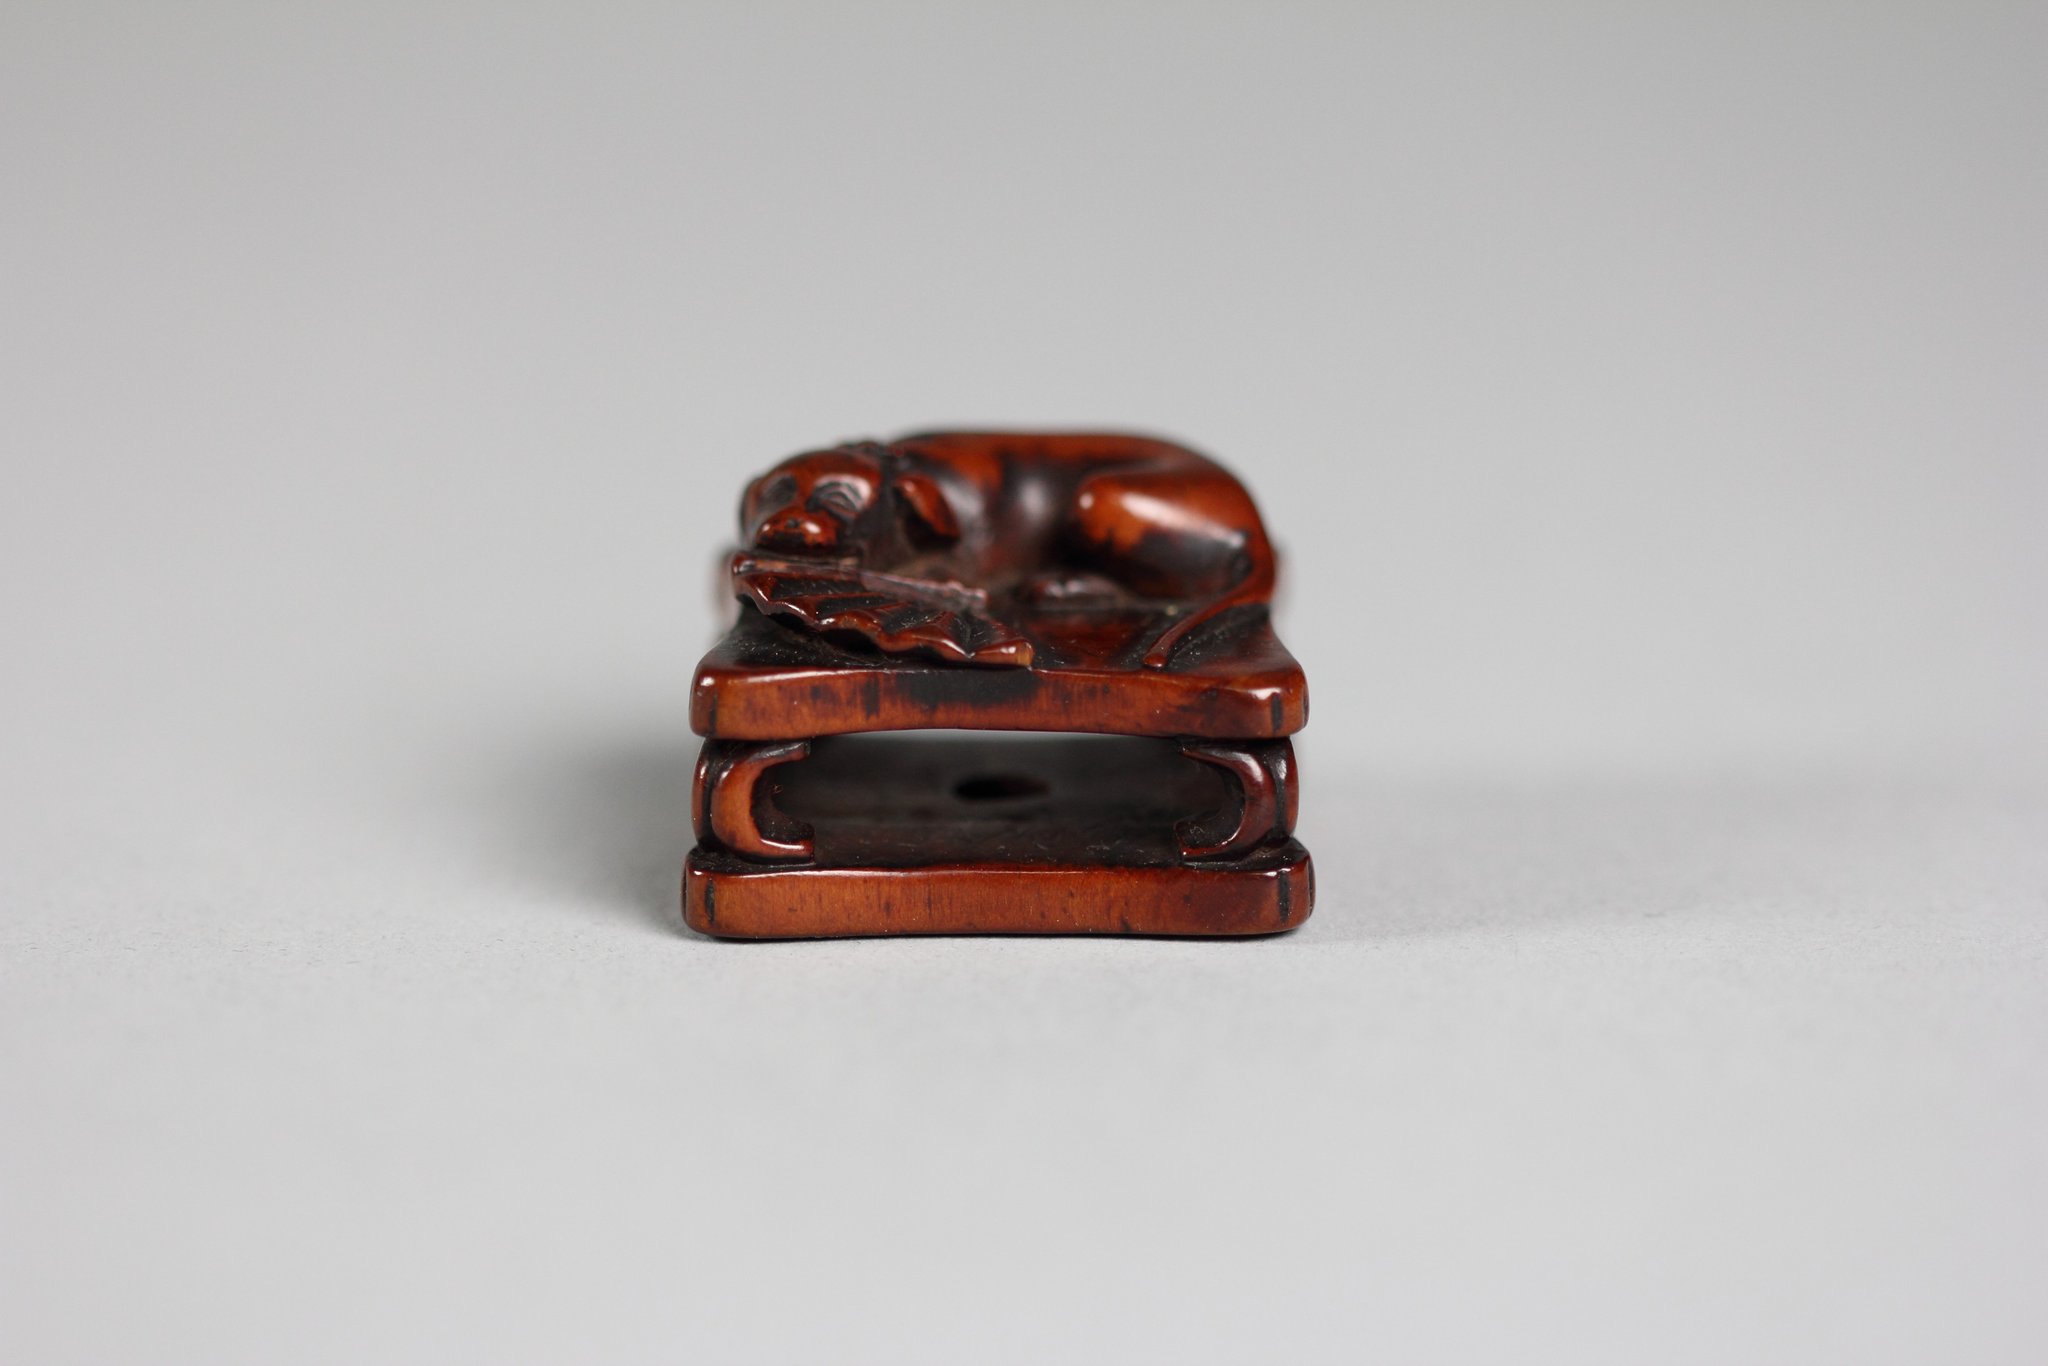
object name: netsuke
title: Netsuke of Dog and Fan on a Bench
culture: japanese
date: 1801-1900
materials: wood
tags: dogs